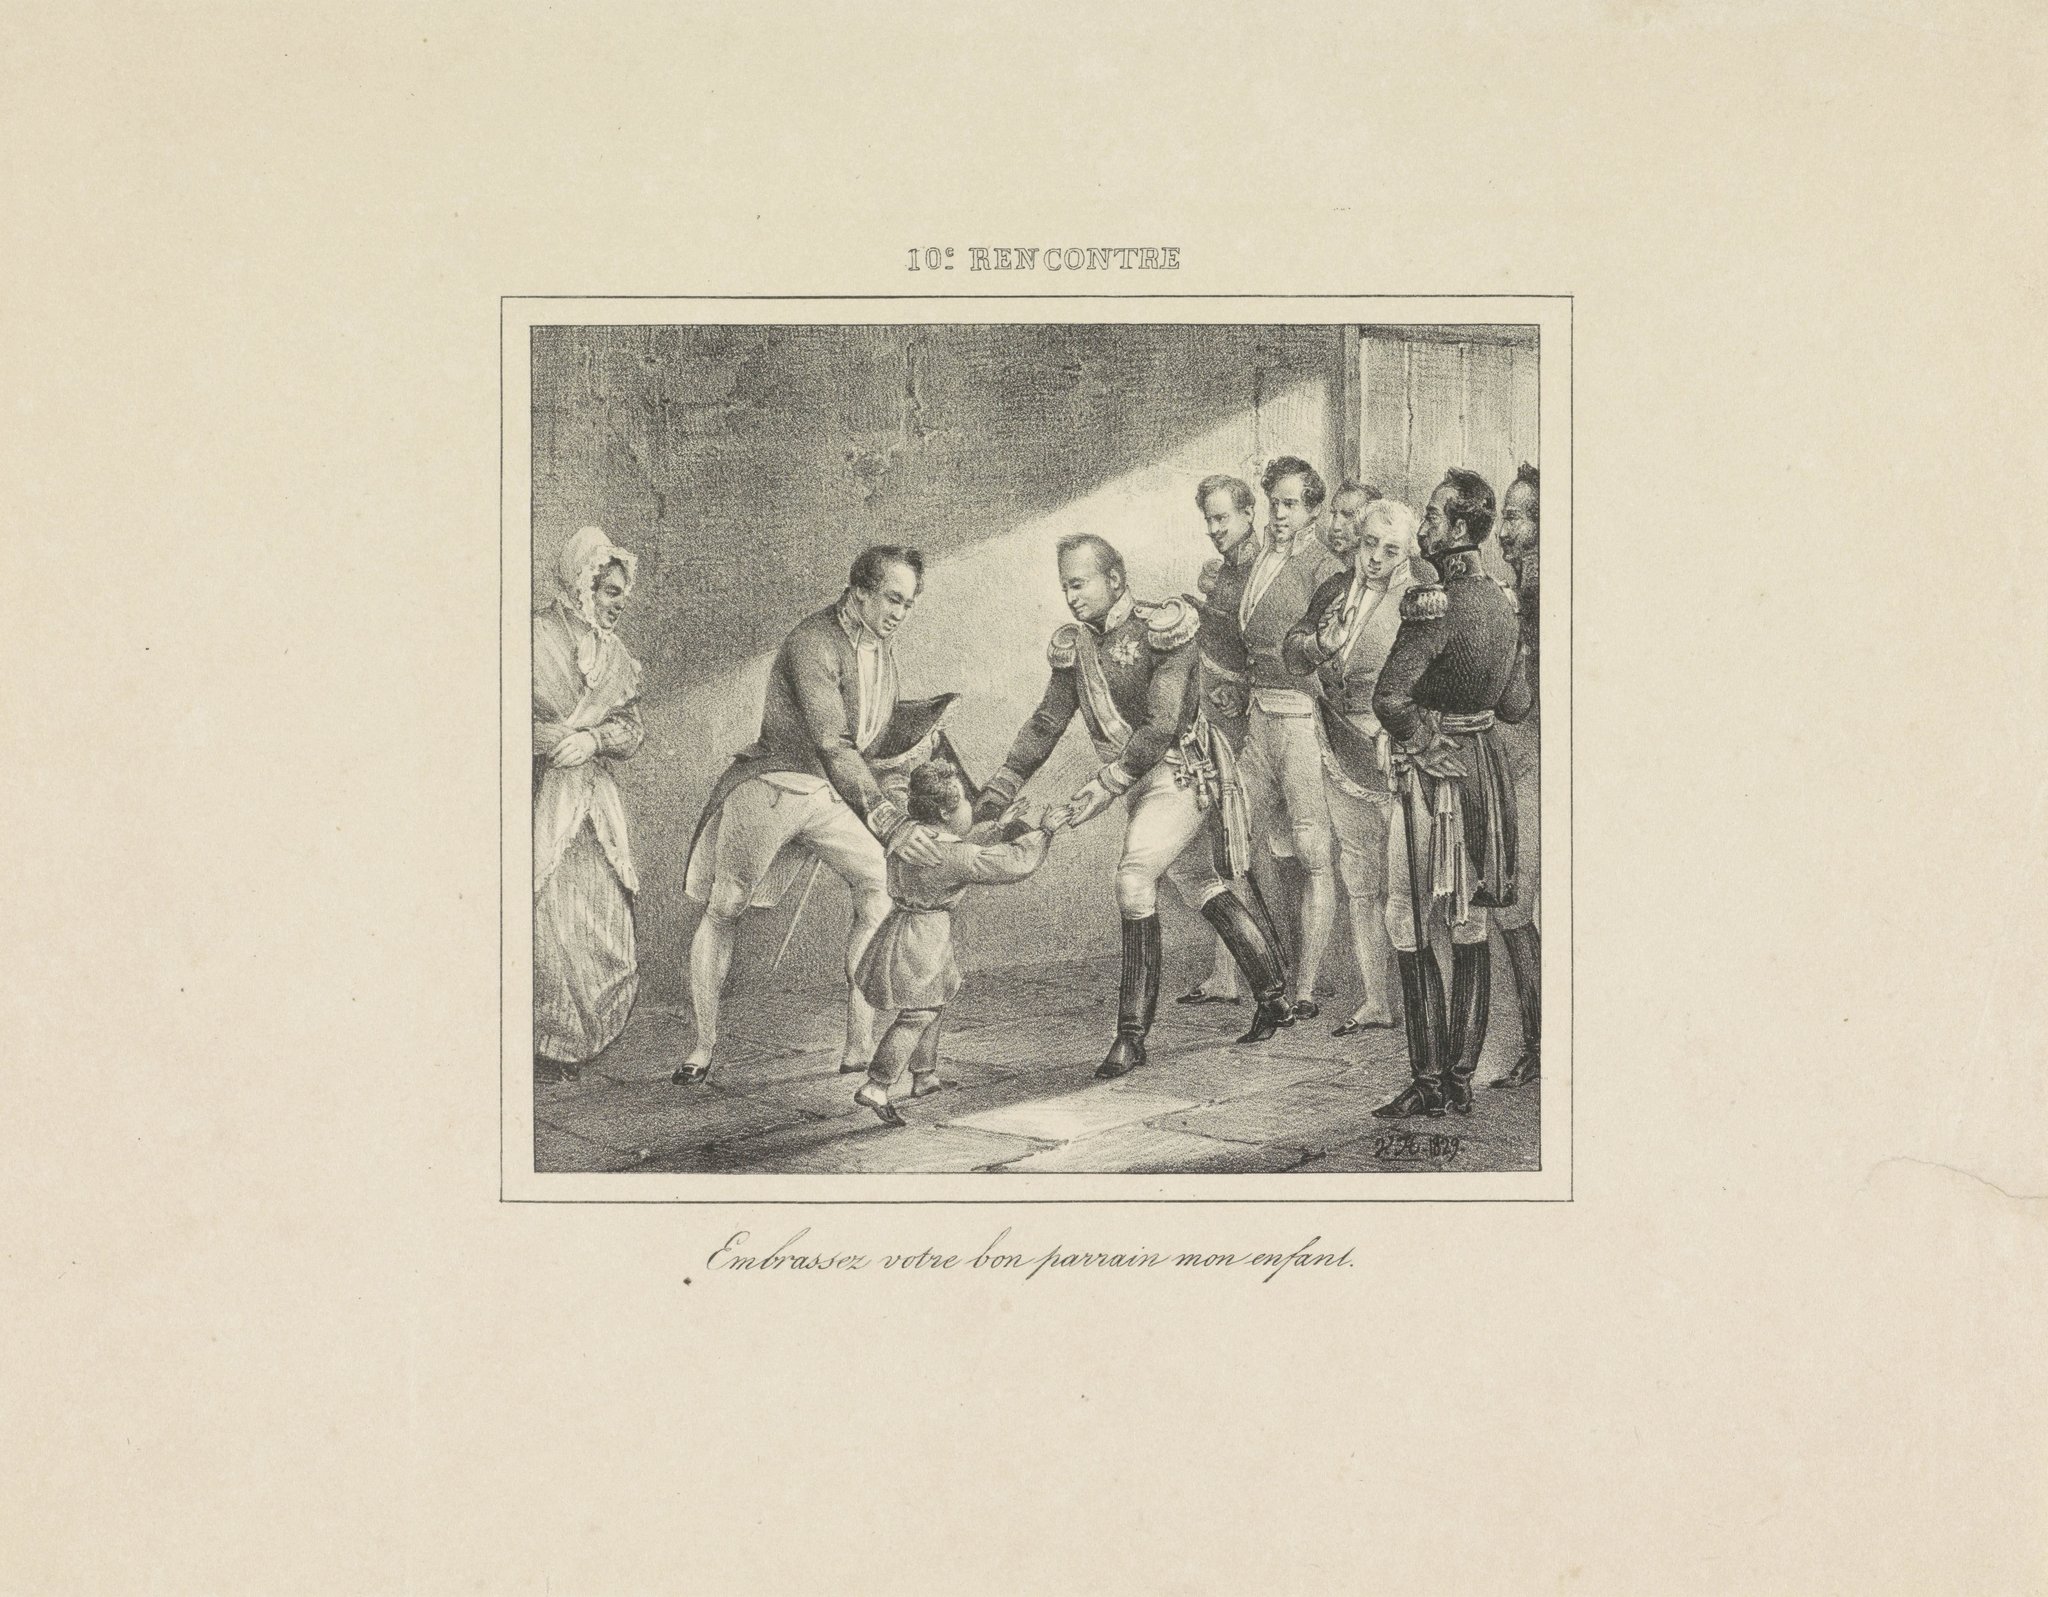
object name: print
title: Ontmoetingen met koning Willem I, 1829-1830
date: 1829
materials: paper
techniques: lithograph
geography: brussels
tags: the hague, berlin, william i of the netherlands, ruler in informal contact with his subjects, godfather and godmother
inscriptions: collector's mark: Lugt 2228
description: De koning ontmoet een kind waarover hij peet is. Met eenregelig onderschrift. Onderdeel van de serie van 24 platen met ontmoetingen met koning Willem I, verschenen onder de titel 'Les rencontres' in 1829-1830.